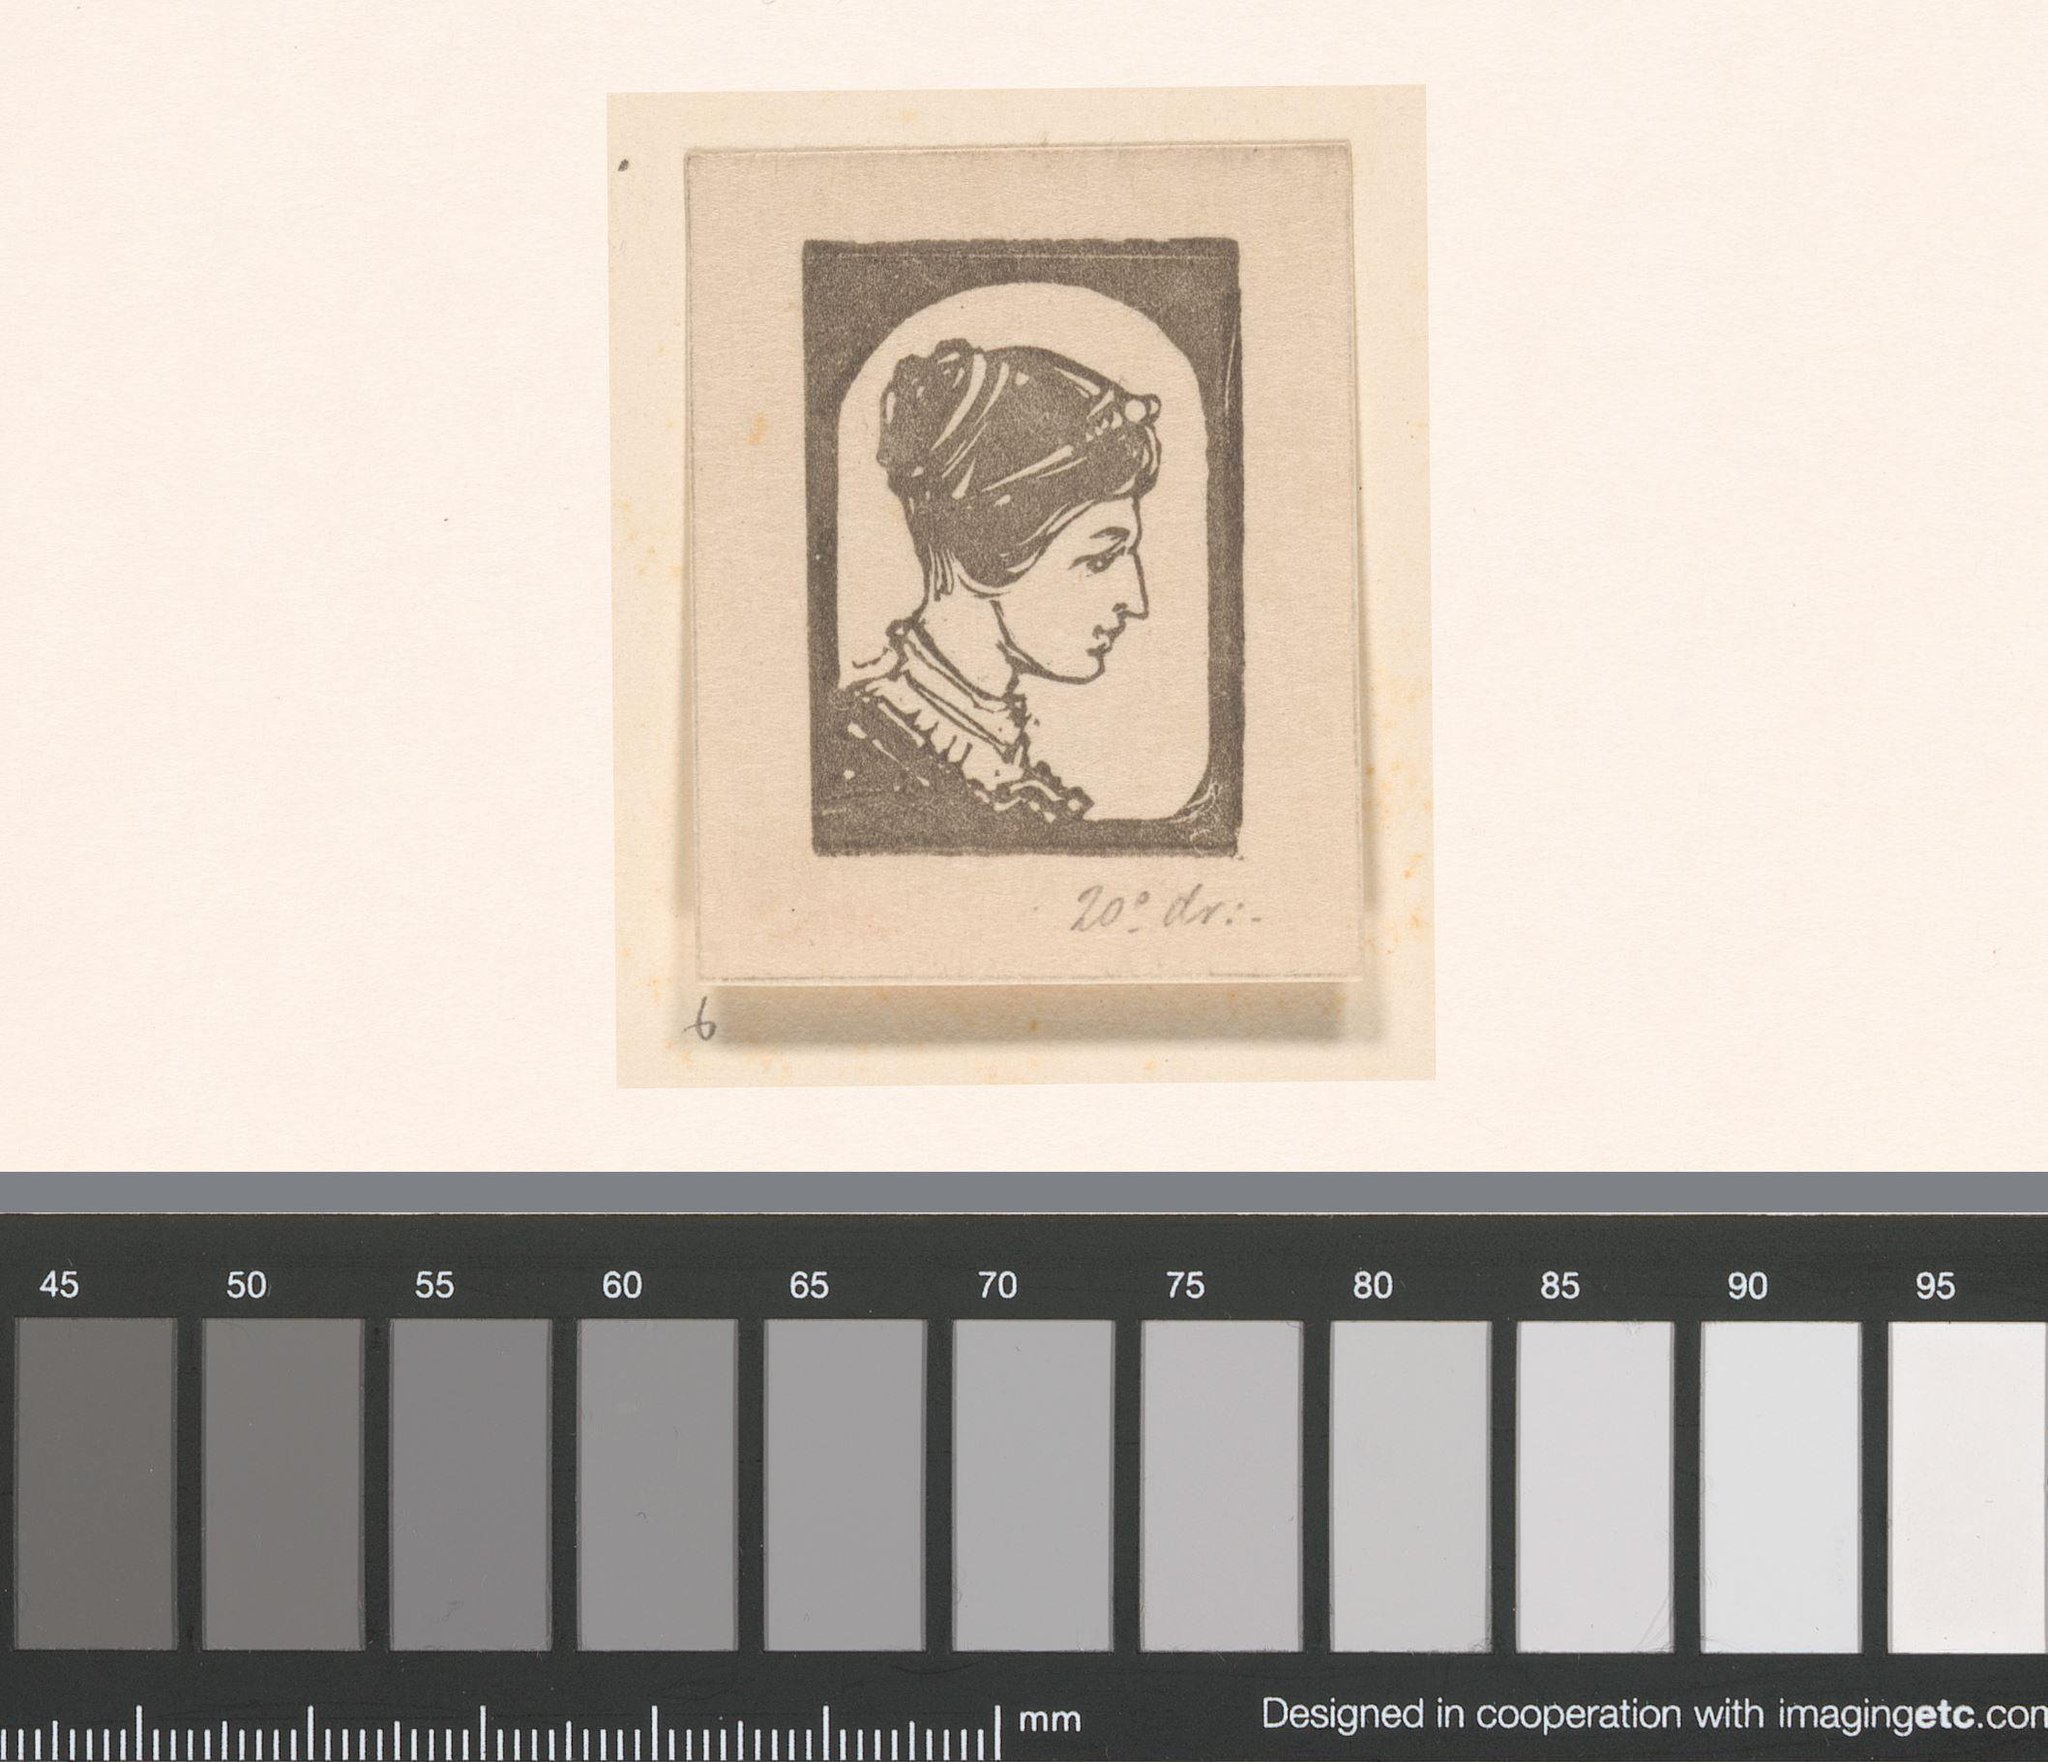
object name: print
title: Hoofd van een vrouw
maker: bernard willem wierink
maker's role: draughtsman, print maker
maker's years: 1856-1939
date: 1866-1939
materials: paper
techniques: relief print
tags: anonymous historical person portrayed - bb - woman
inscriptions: collector's mark: Lugt 2228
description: Deze prent is vermoedelijk een plaatsnede, ook al wordt in de literatuur veelal gesproken over een houtsnede. Voor zover Wierink zijn prenten in hoogdruk zelf nader heeft omschreven, heeft hij altijd de term 'plaatsnede' gebruikt.